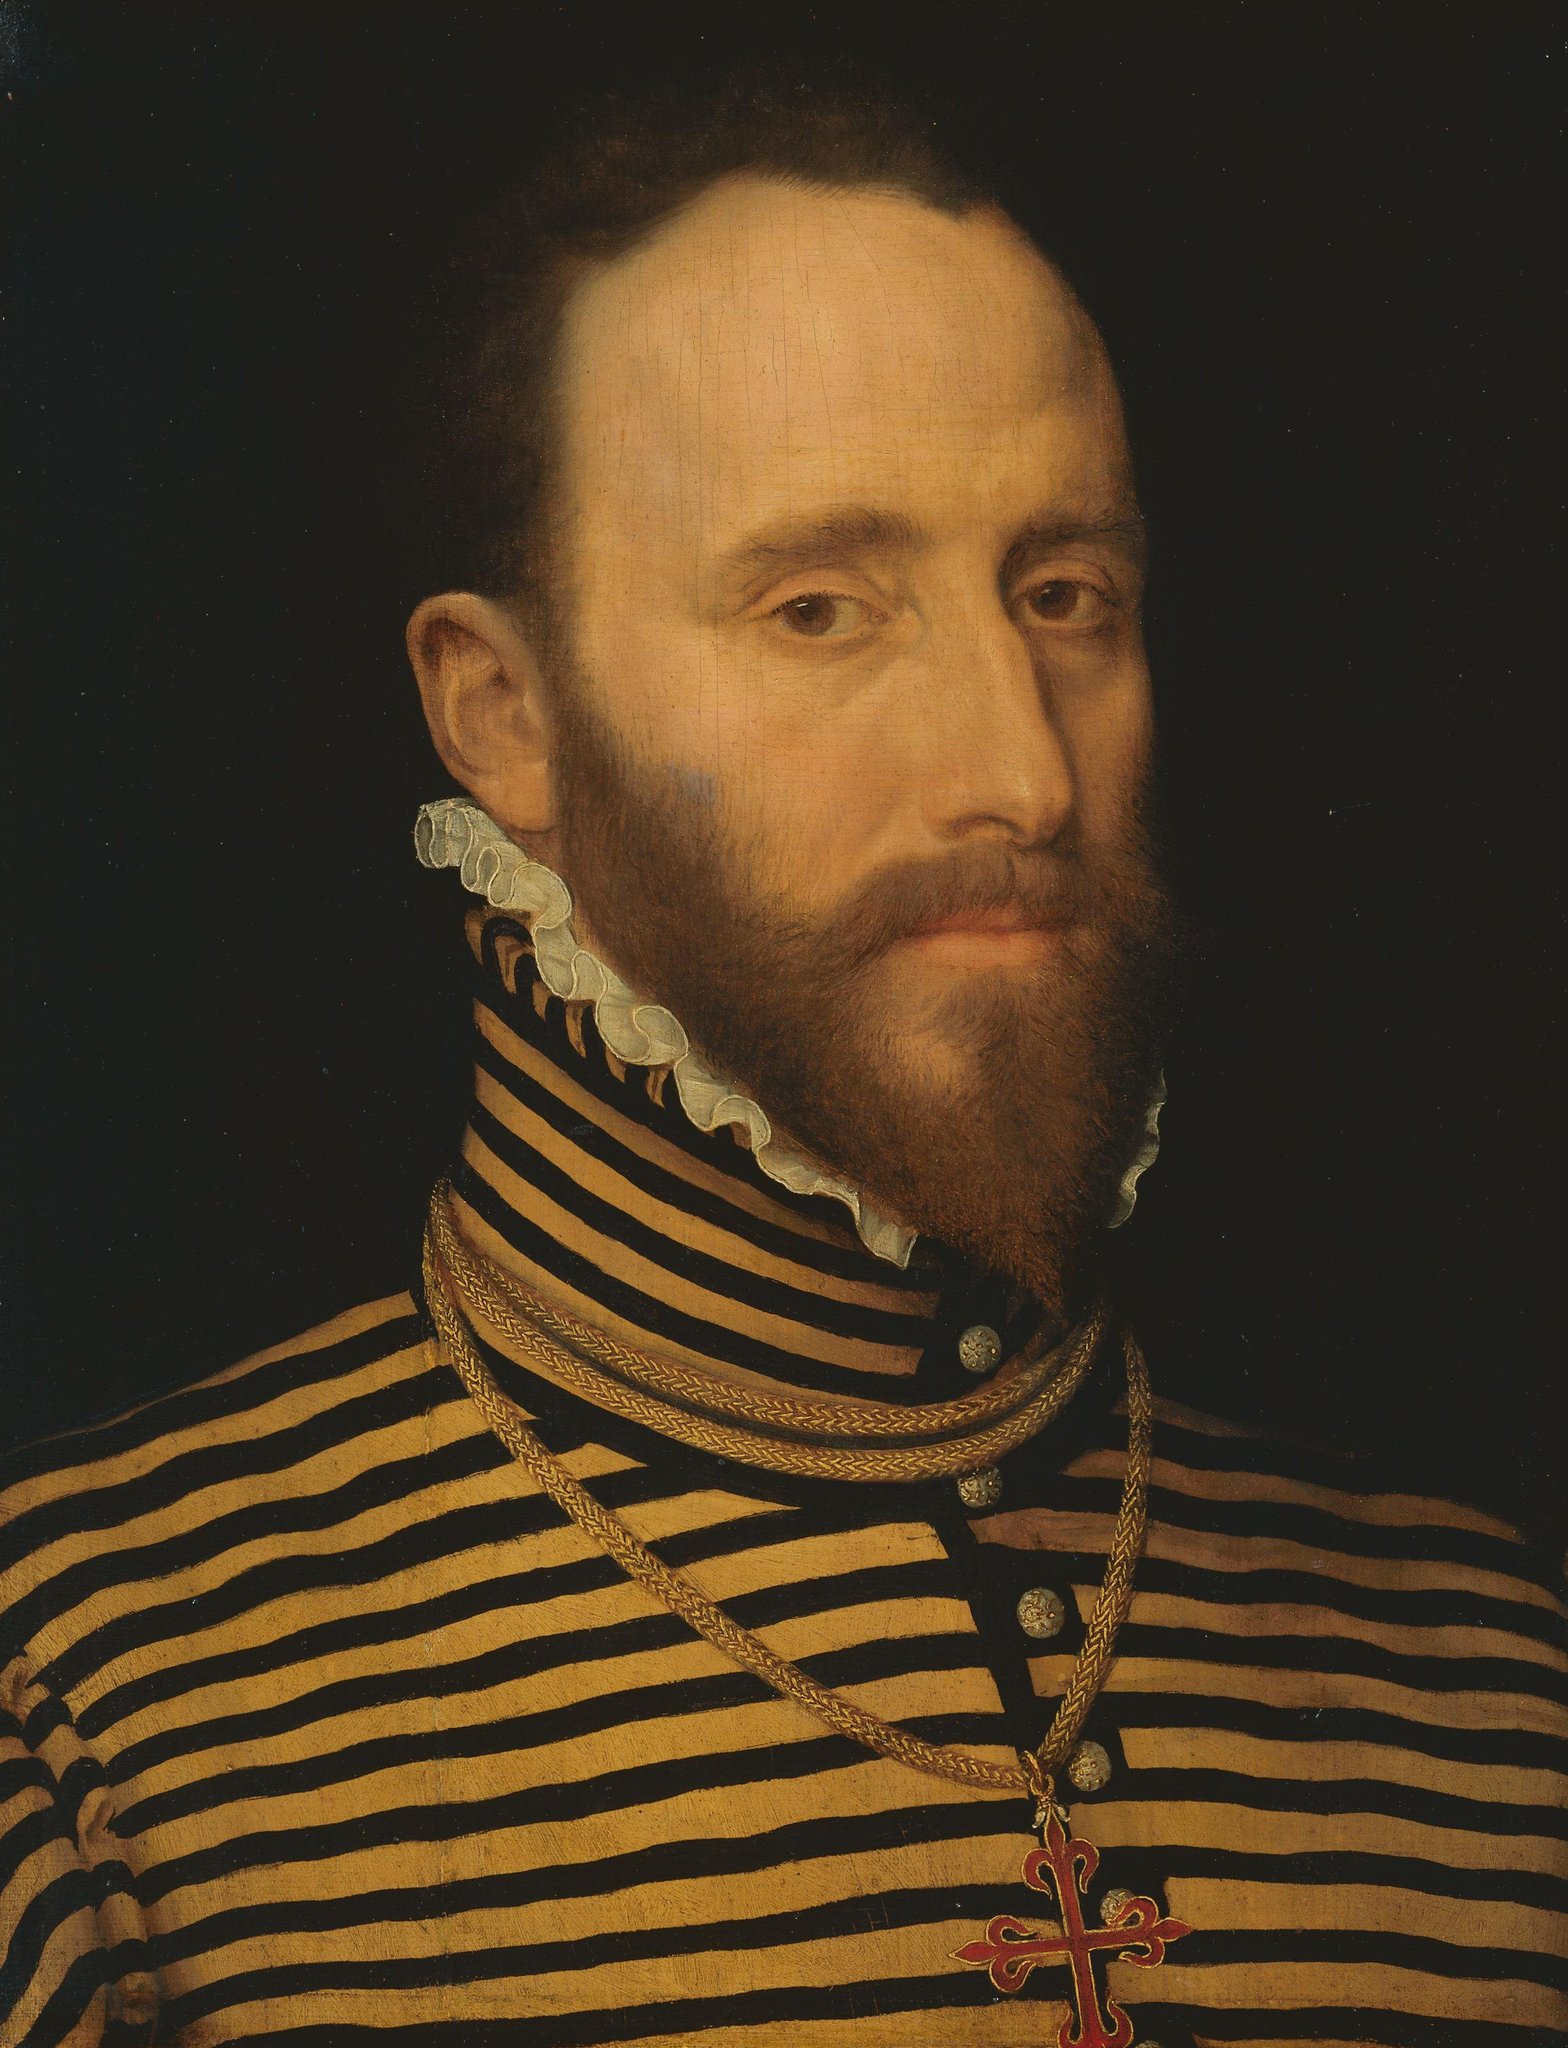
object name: painting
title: Portrait of a Knight of the Order of Calatrava, probably of the Sorias or Soreau Lineage (Sorel)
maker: frans pourbus (i)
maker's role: painter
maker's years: 1545-1581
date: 1555-1581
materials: oil, panel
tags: knighthood order, anonymous historical person portrayed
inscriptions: inscription: ‘Jean Prince de Soreau, Prieur de Cosne’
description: Portret van een ridder in de orde van Calatrava, vermoedelijk van het geslacht Sorias of Soreau (Sorel). Buste naar links, gekleed in een gestreept wambuis, om de hals een ketting met een ordeteken.